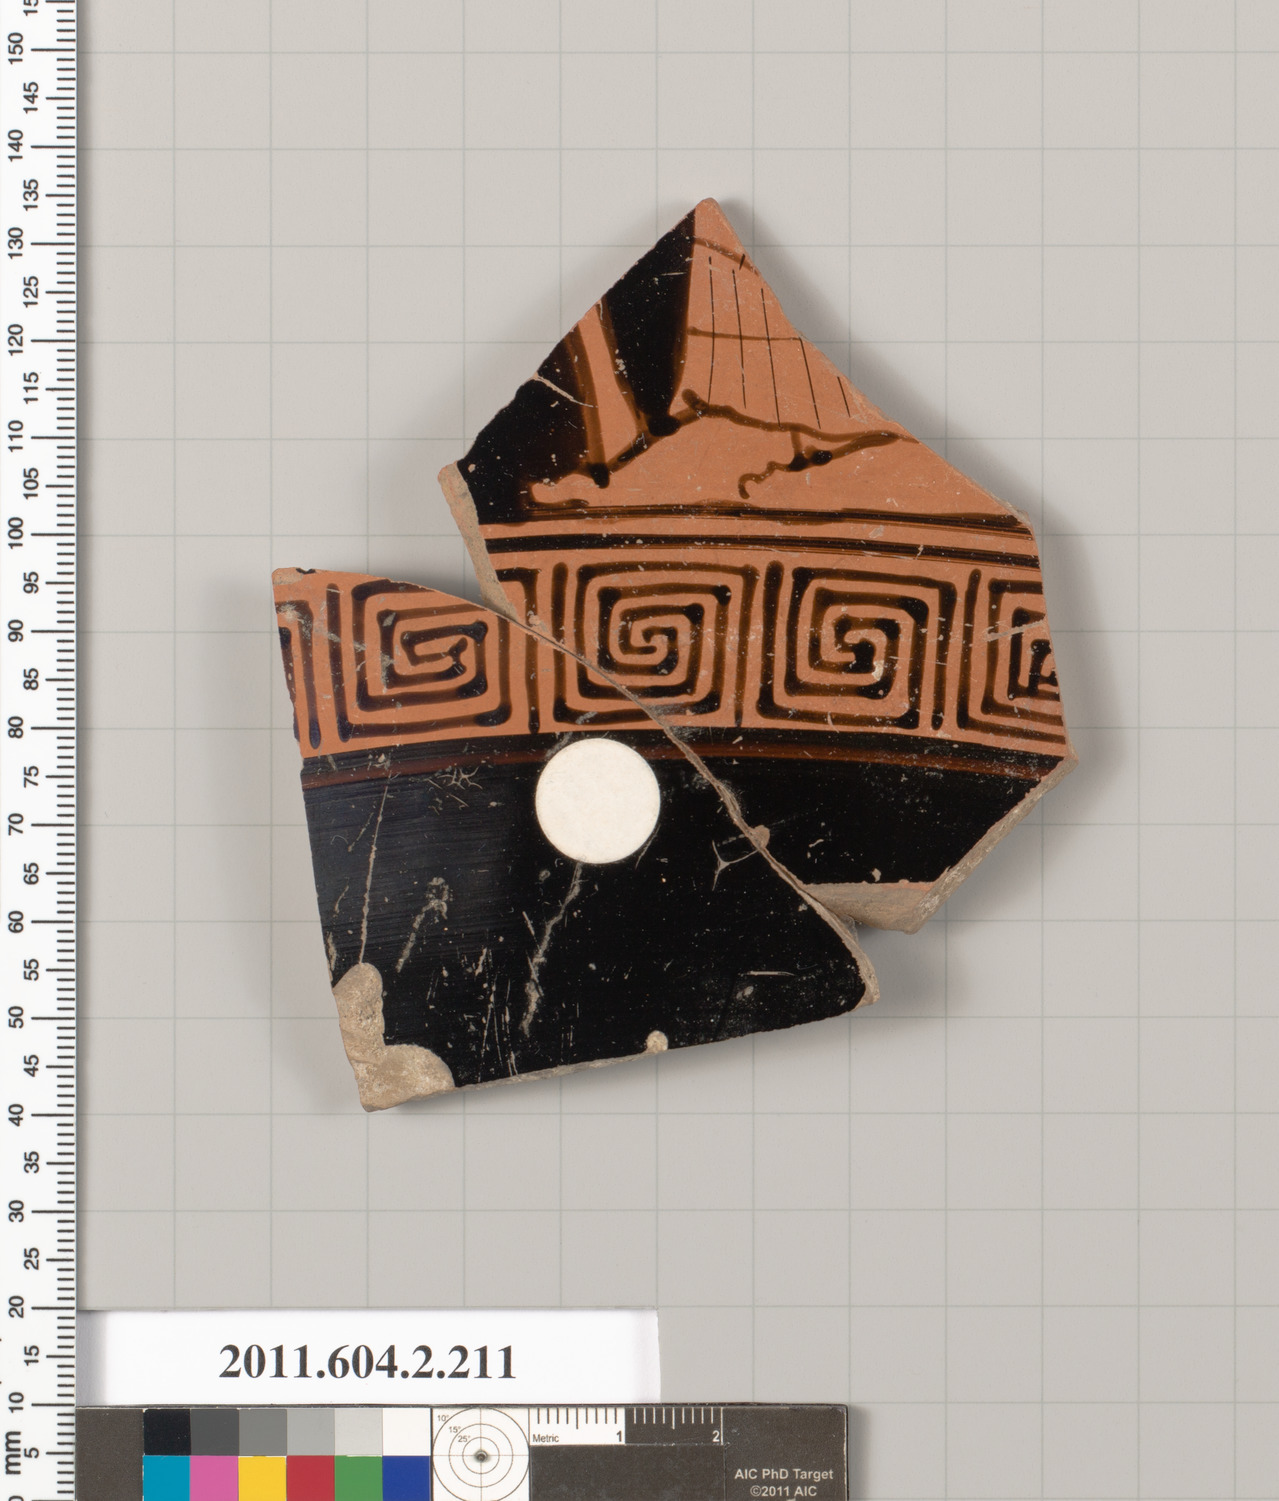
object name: stamnos fragment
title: Terracotta fragment of a stamnos (jar)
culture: greek, attic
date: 450-440 BCE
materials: terracotta